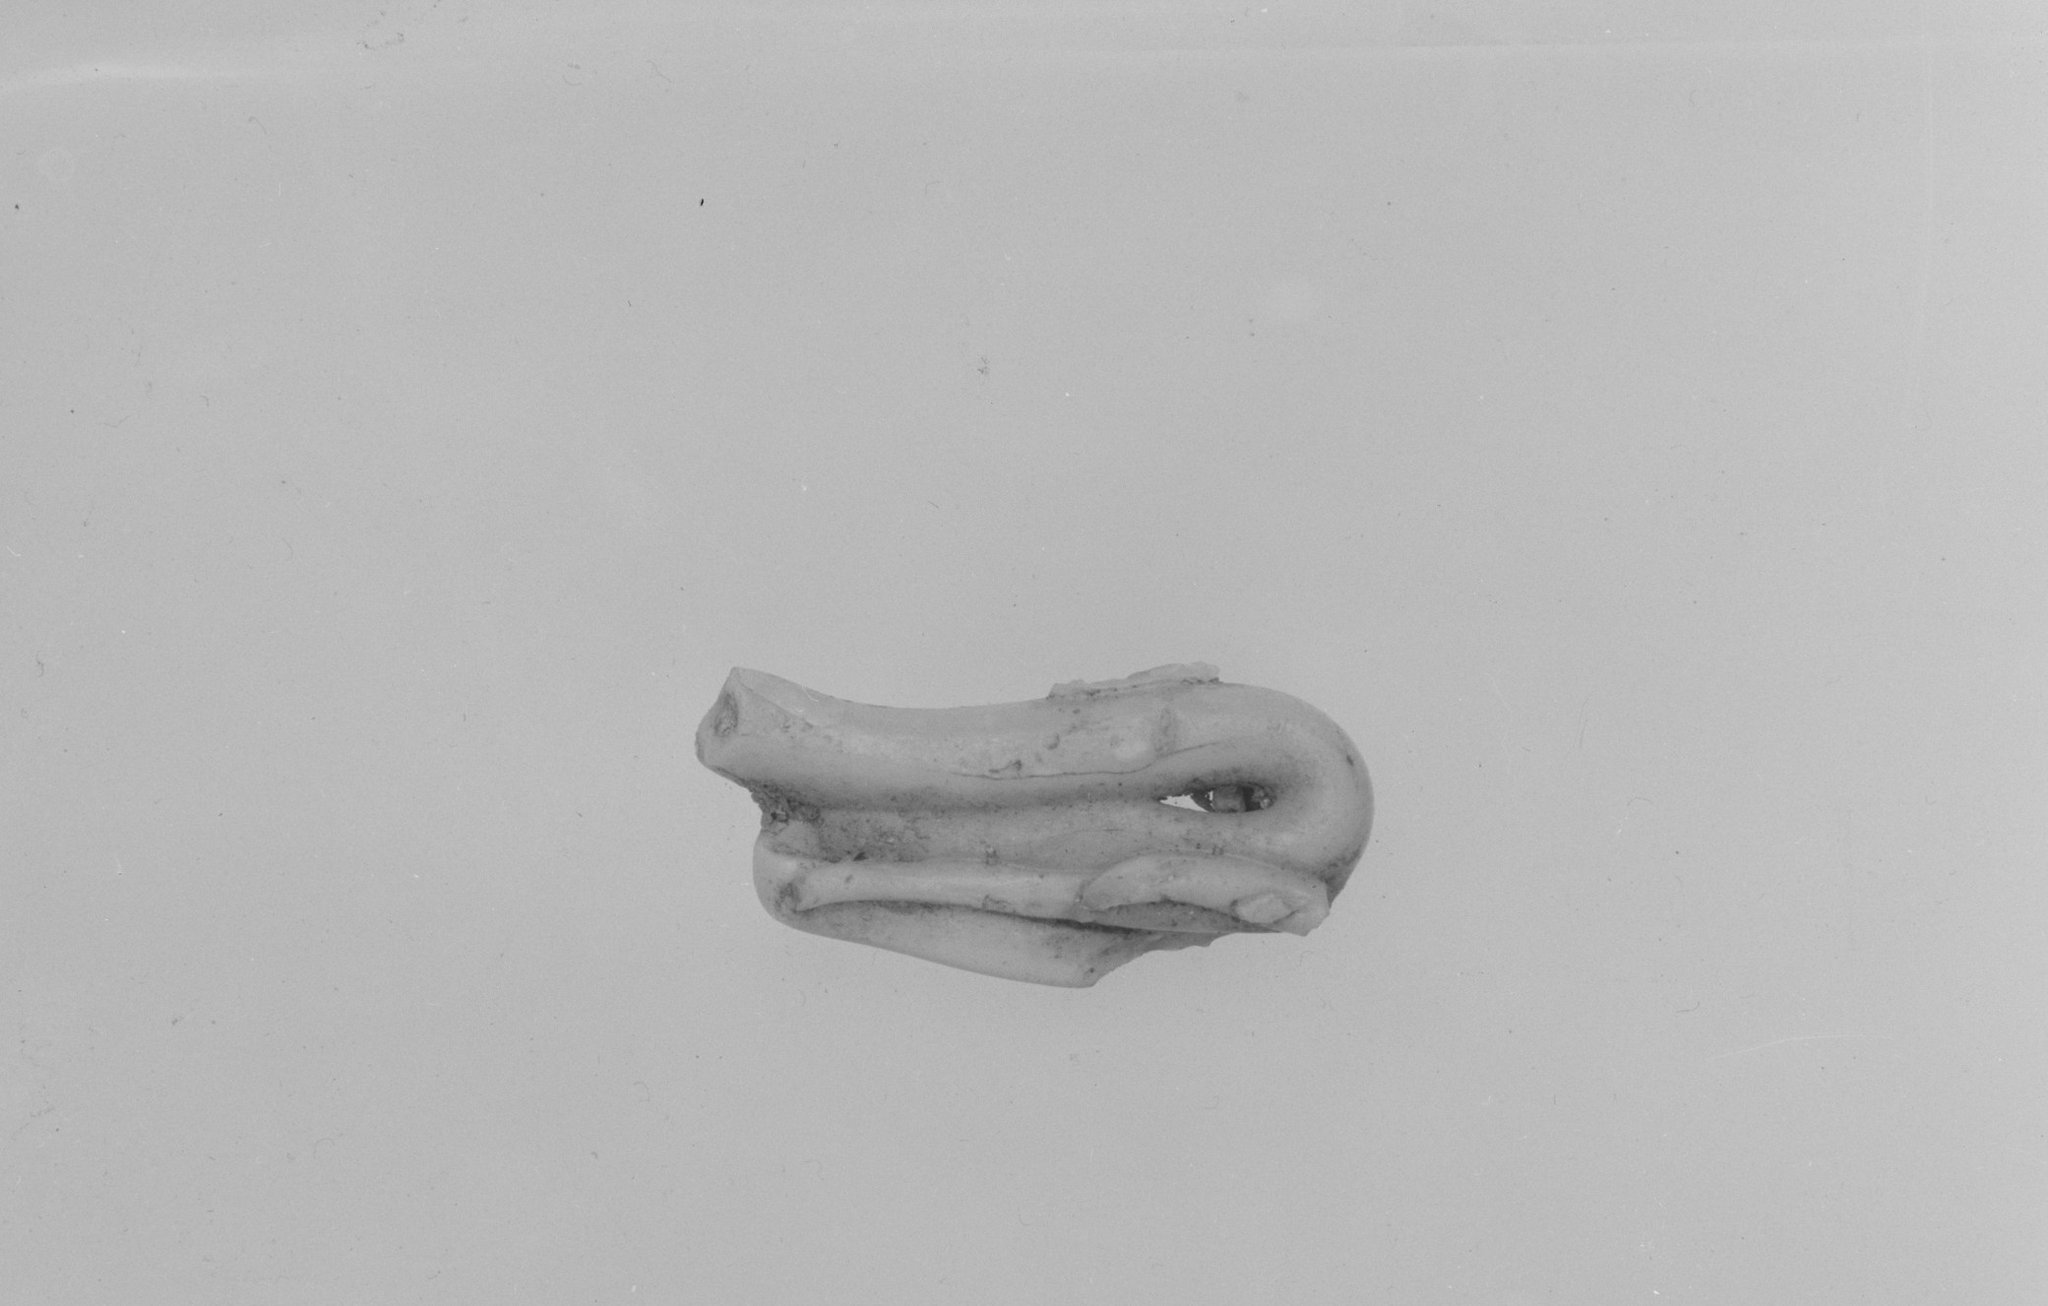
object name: fragment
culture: american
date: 1700-1800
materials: glass, lead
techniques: glassblowing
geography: united states